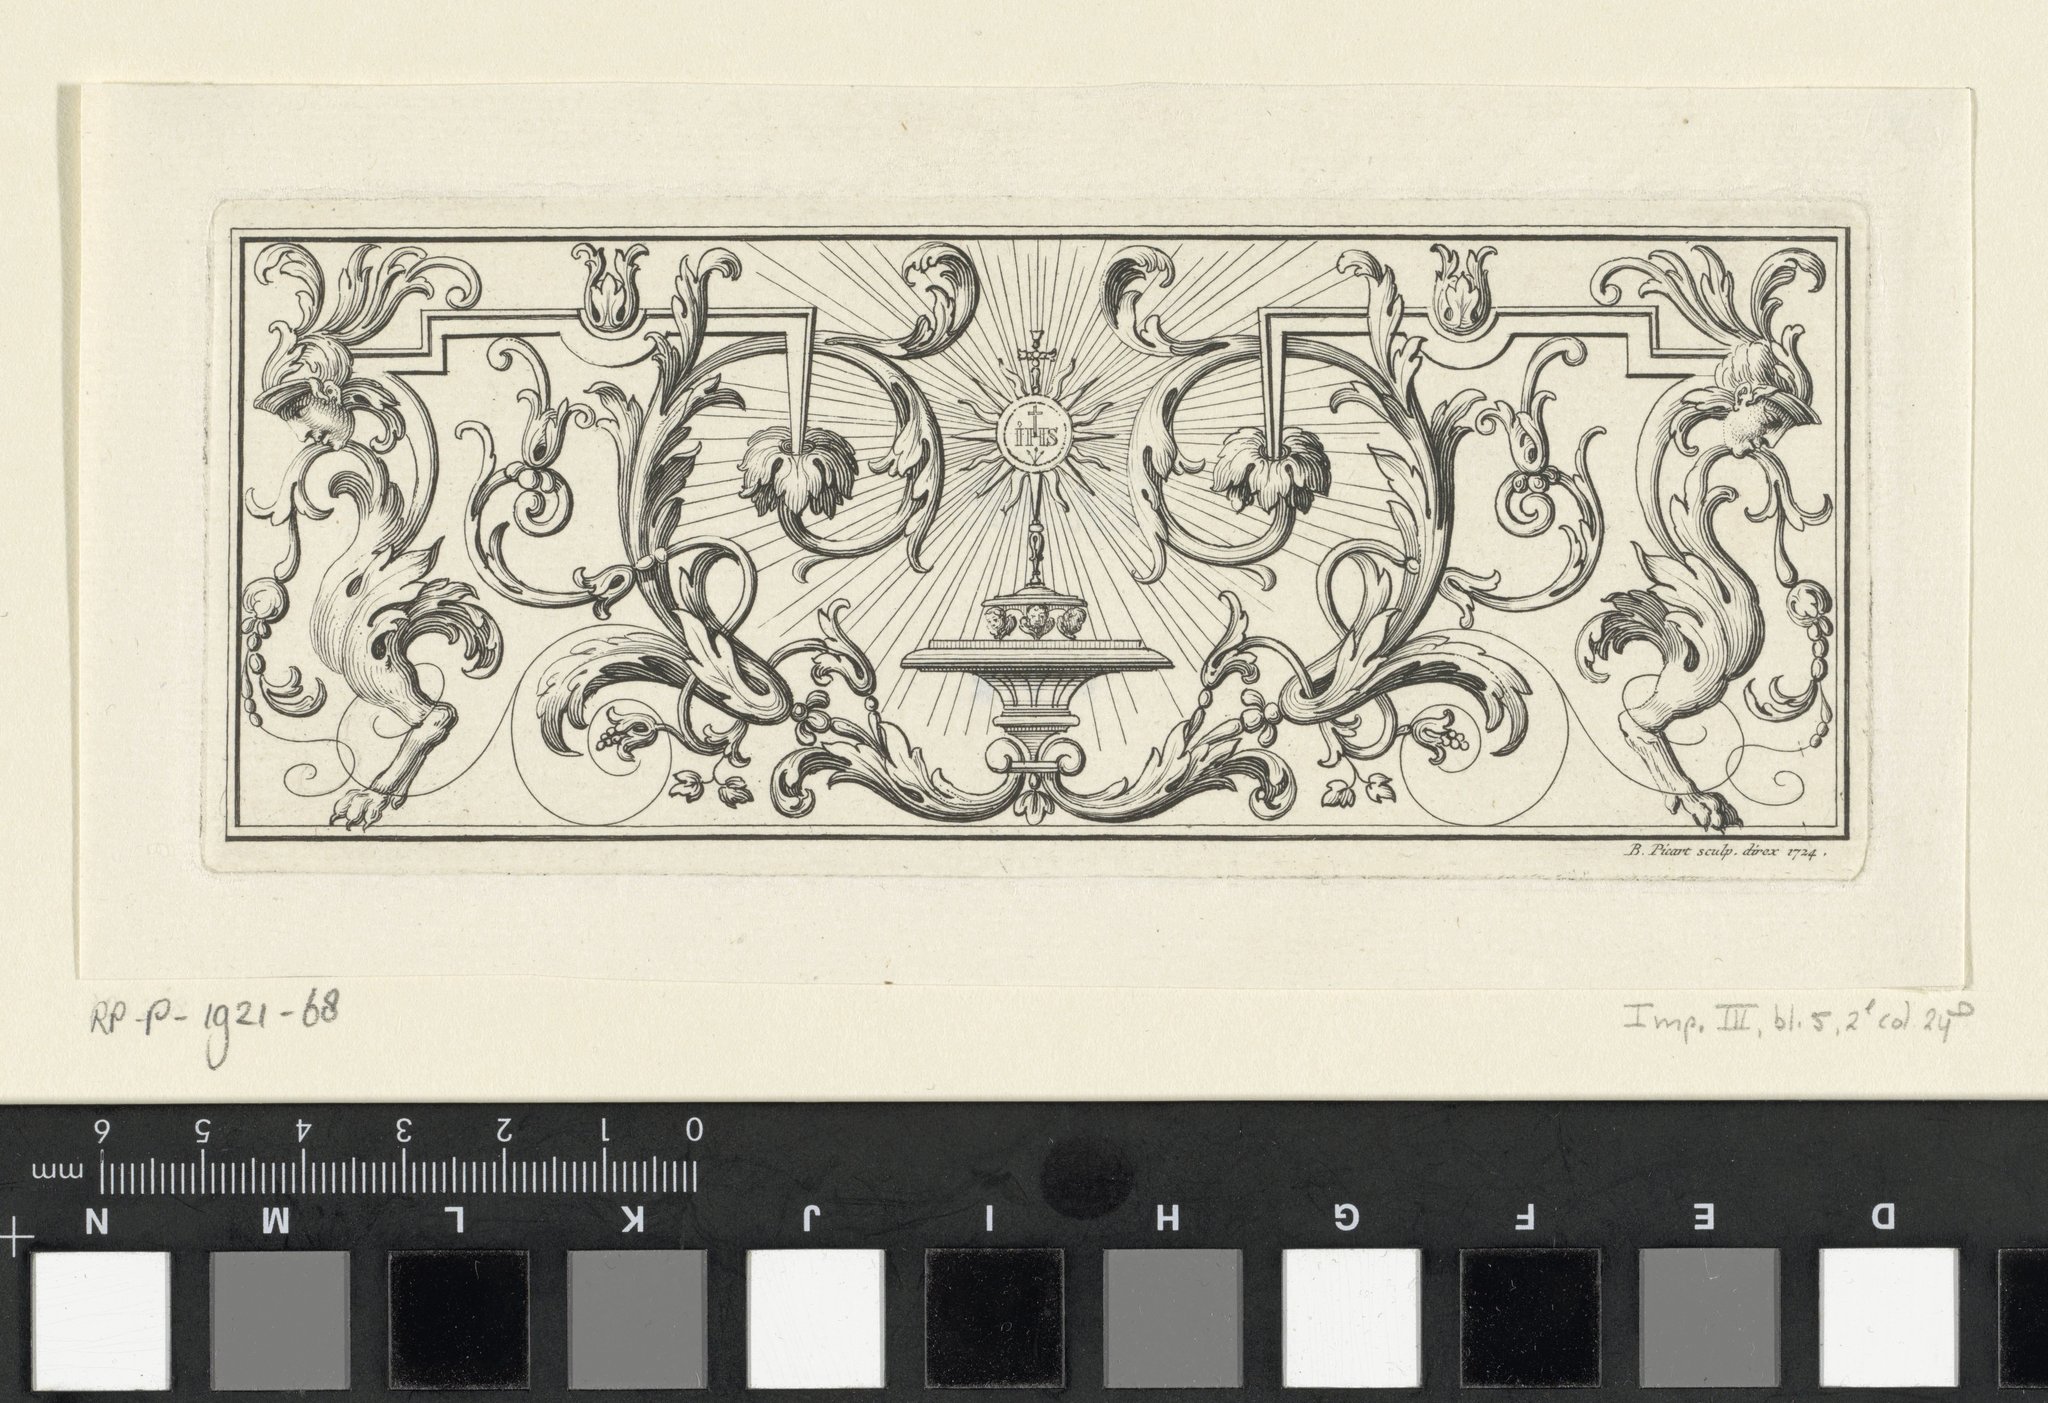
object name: print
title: Ornament met monstrans met Christusmonogram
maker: bernard picart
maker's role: draughtsman, print maker, publisher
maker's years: 1673-1733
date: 1724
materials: paper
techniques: engraving, etching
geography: amsterdam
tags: ihs ('iesus hominum salvator') ~ symbol of christ, foliage, tendrils, branches ~ ornament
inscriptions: collector's mark: Lugt 2233